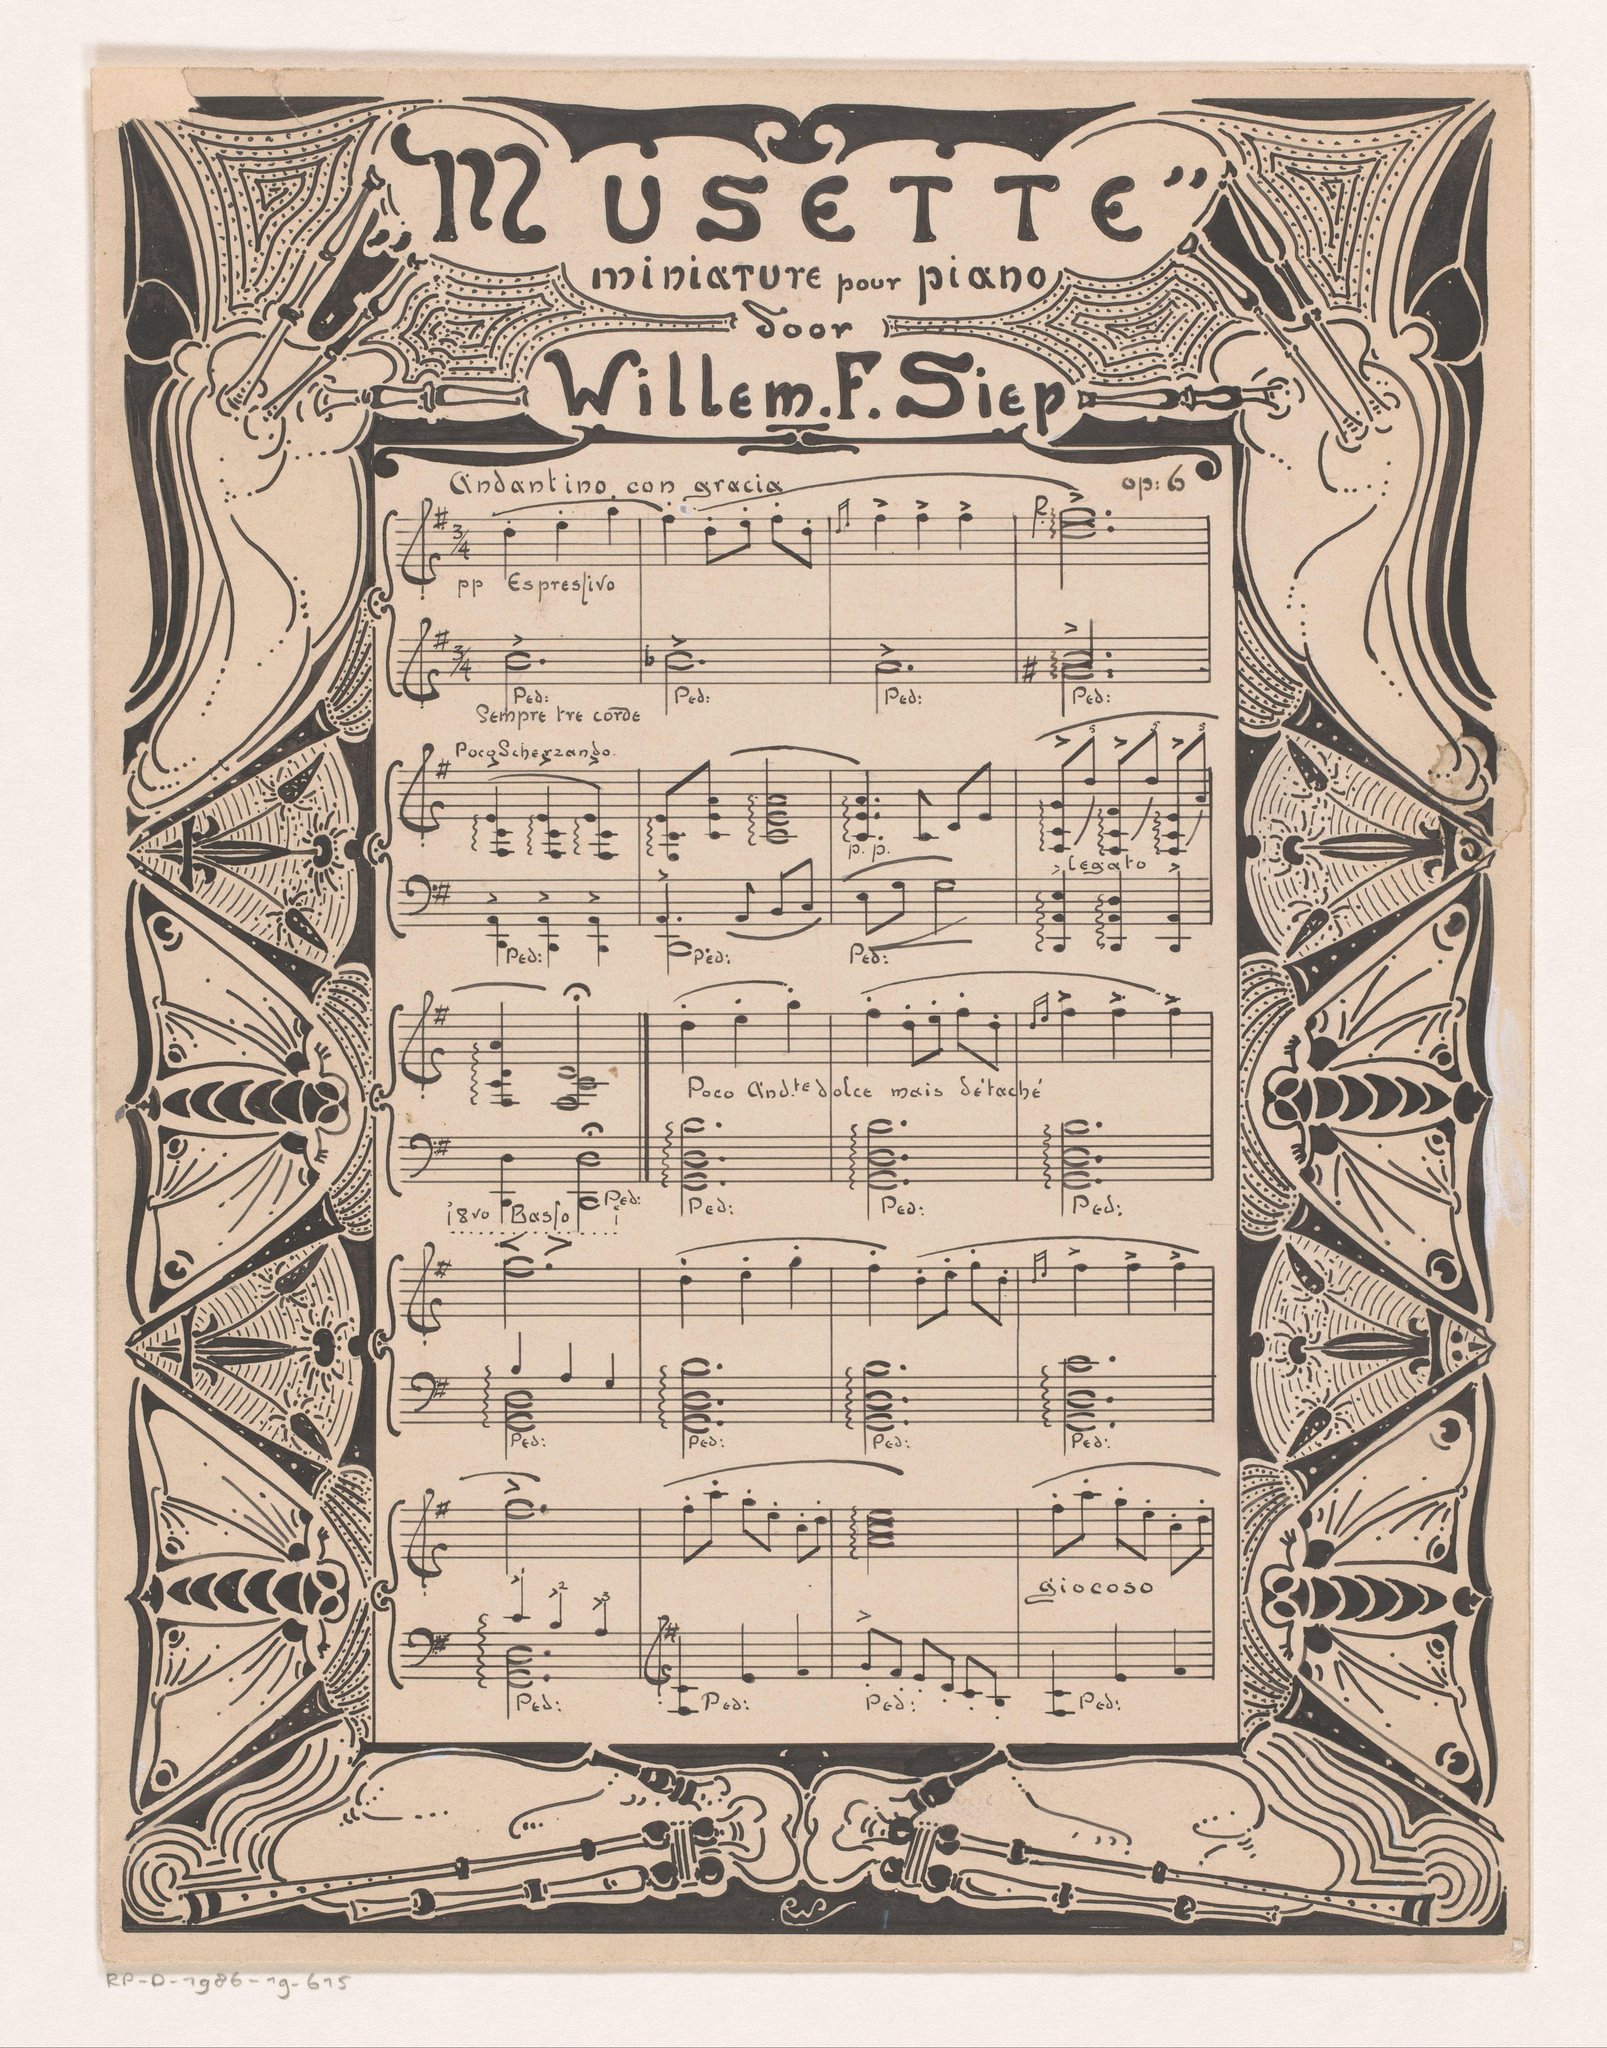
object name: drawing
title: Omlijsting voor het muziekstuk 'Musette' van Willem F. Siep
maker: reinier willem petrus de vries (1874-1953)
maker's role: draughtsman, print maker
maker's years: 1874-1953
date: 1896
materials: paint, ink, paper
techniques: brush, pen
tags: bagpipe, musette, flowers ~ ornament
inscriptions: collector's mark: ‘R:MVS.’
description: Het muziekstuk met omlijsting werd gepubliceerd in: Woord en Beeld. Geïllustreerd maandschrift, juni 1896.